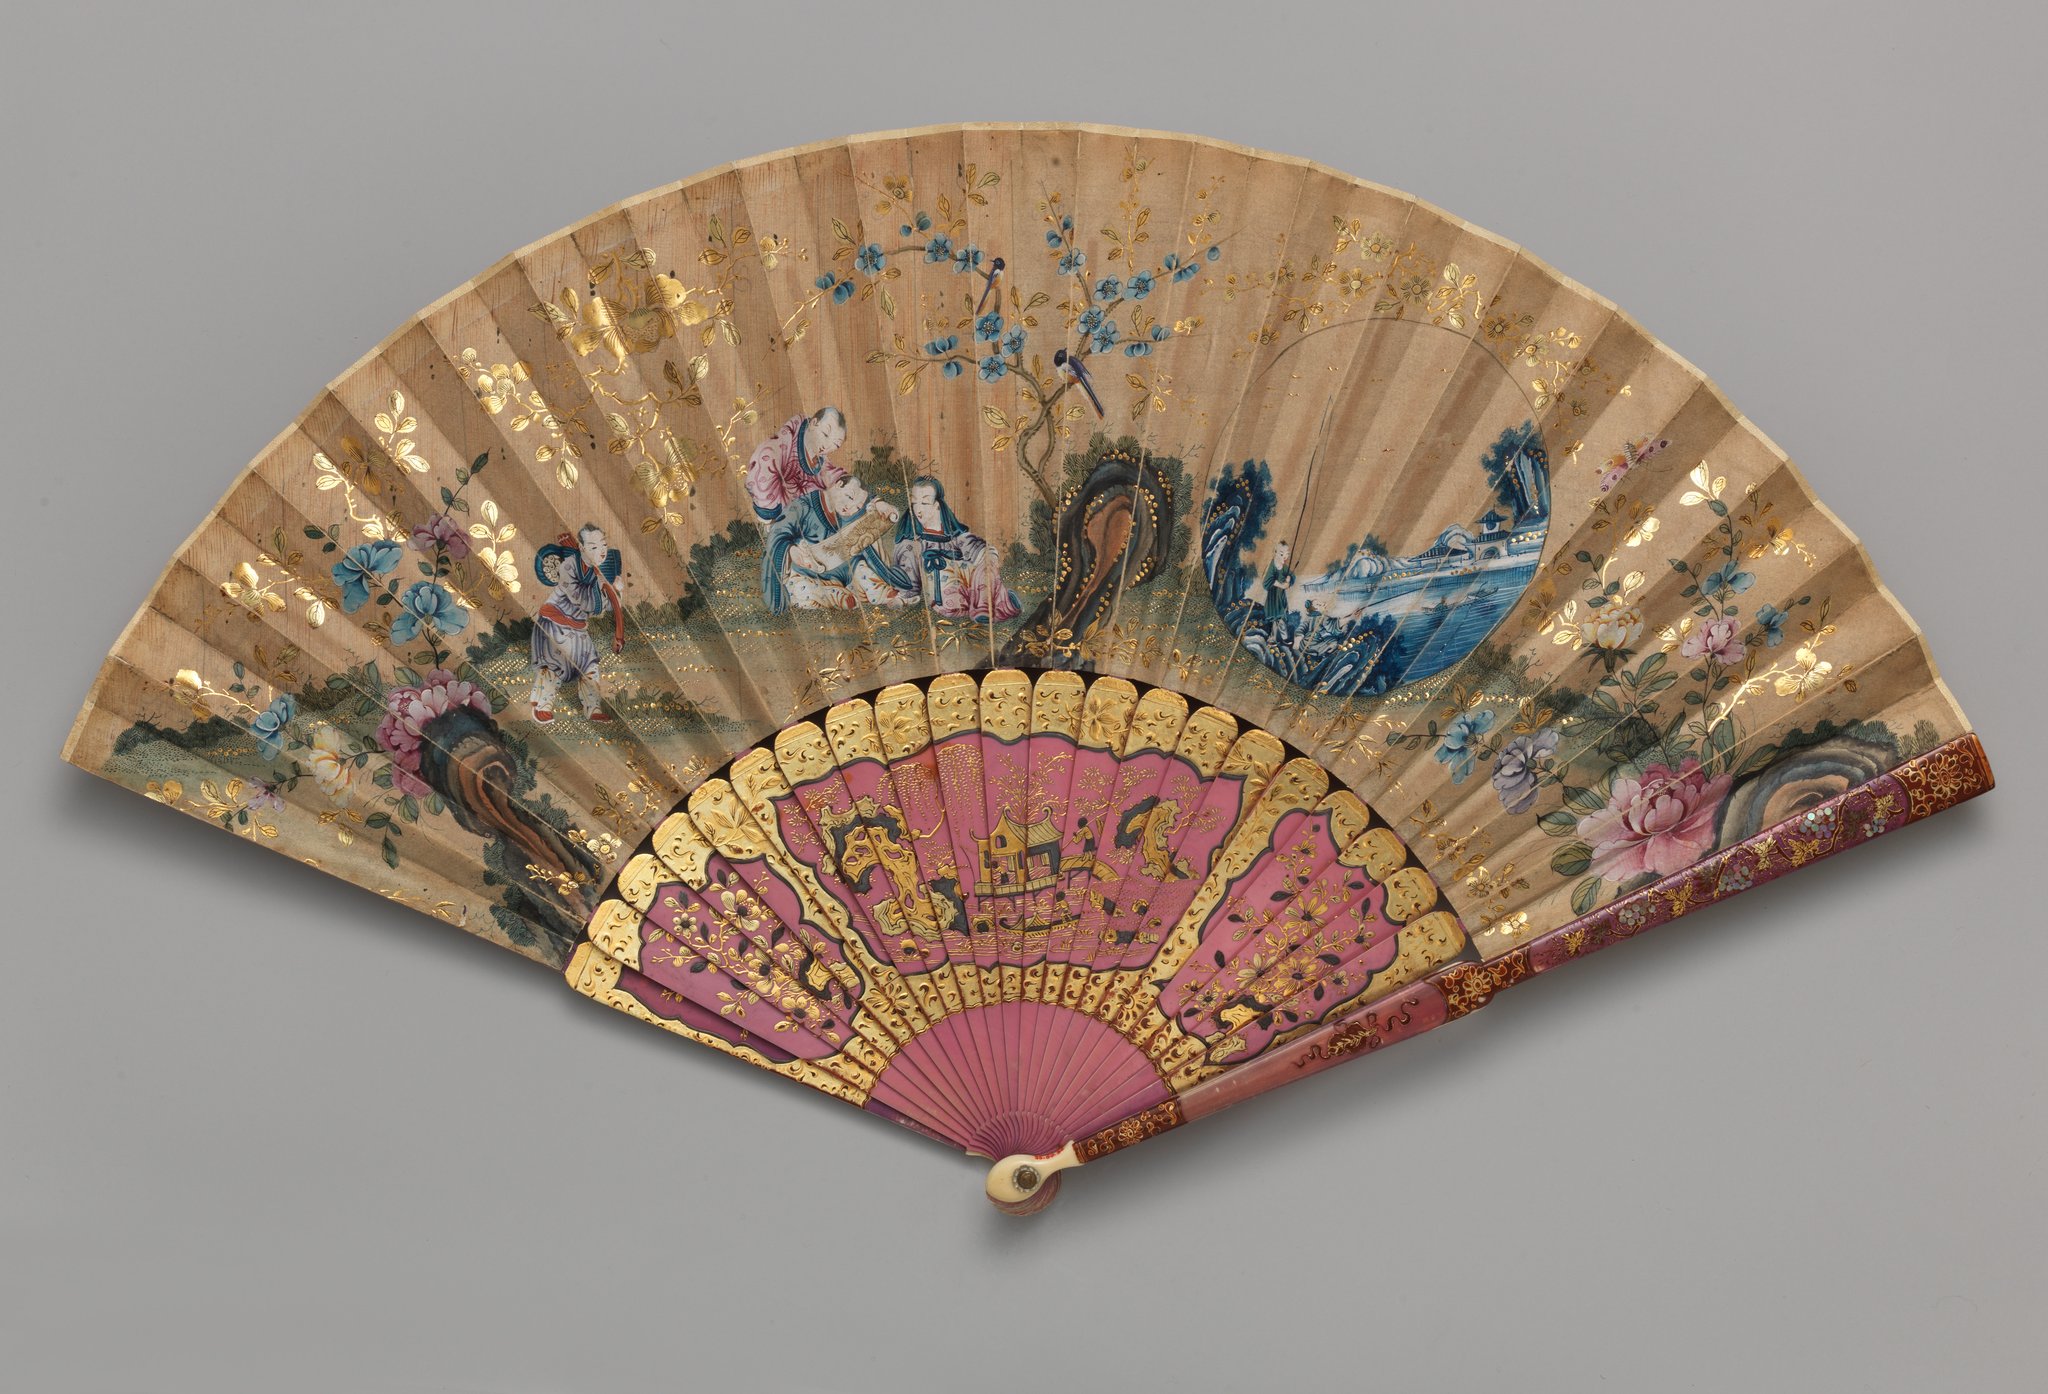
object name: fan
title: Folding Fan with Scene of Figures in a Landscape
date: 1734-1766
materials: ivory, mother of pearl, paper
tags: birds,boys,fishing